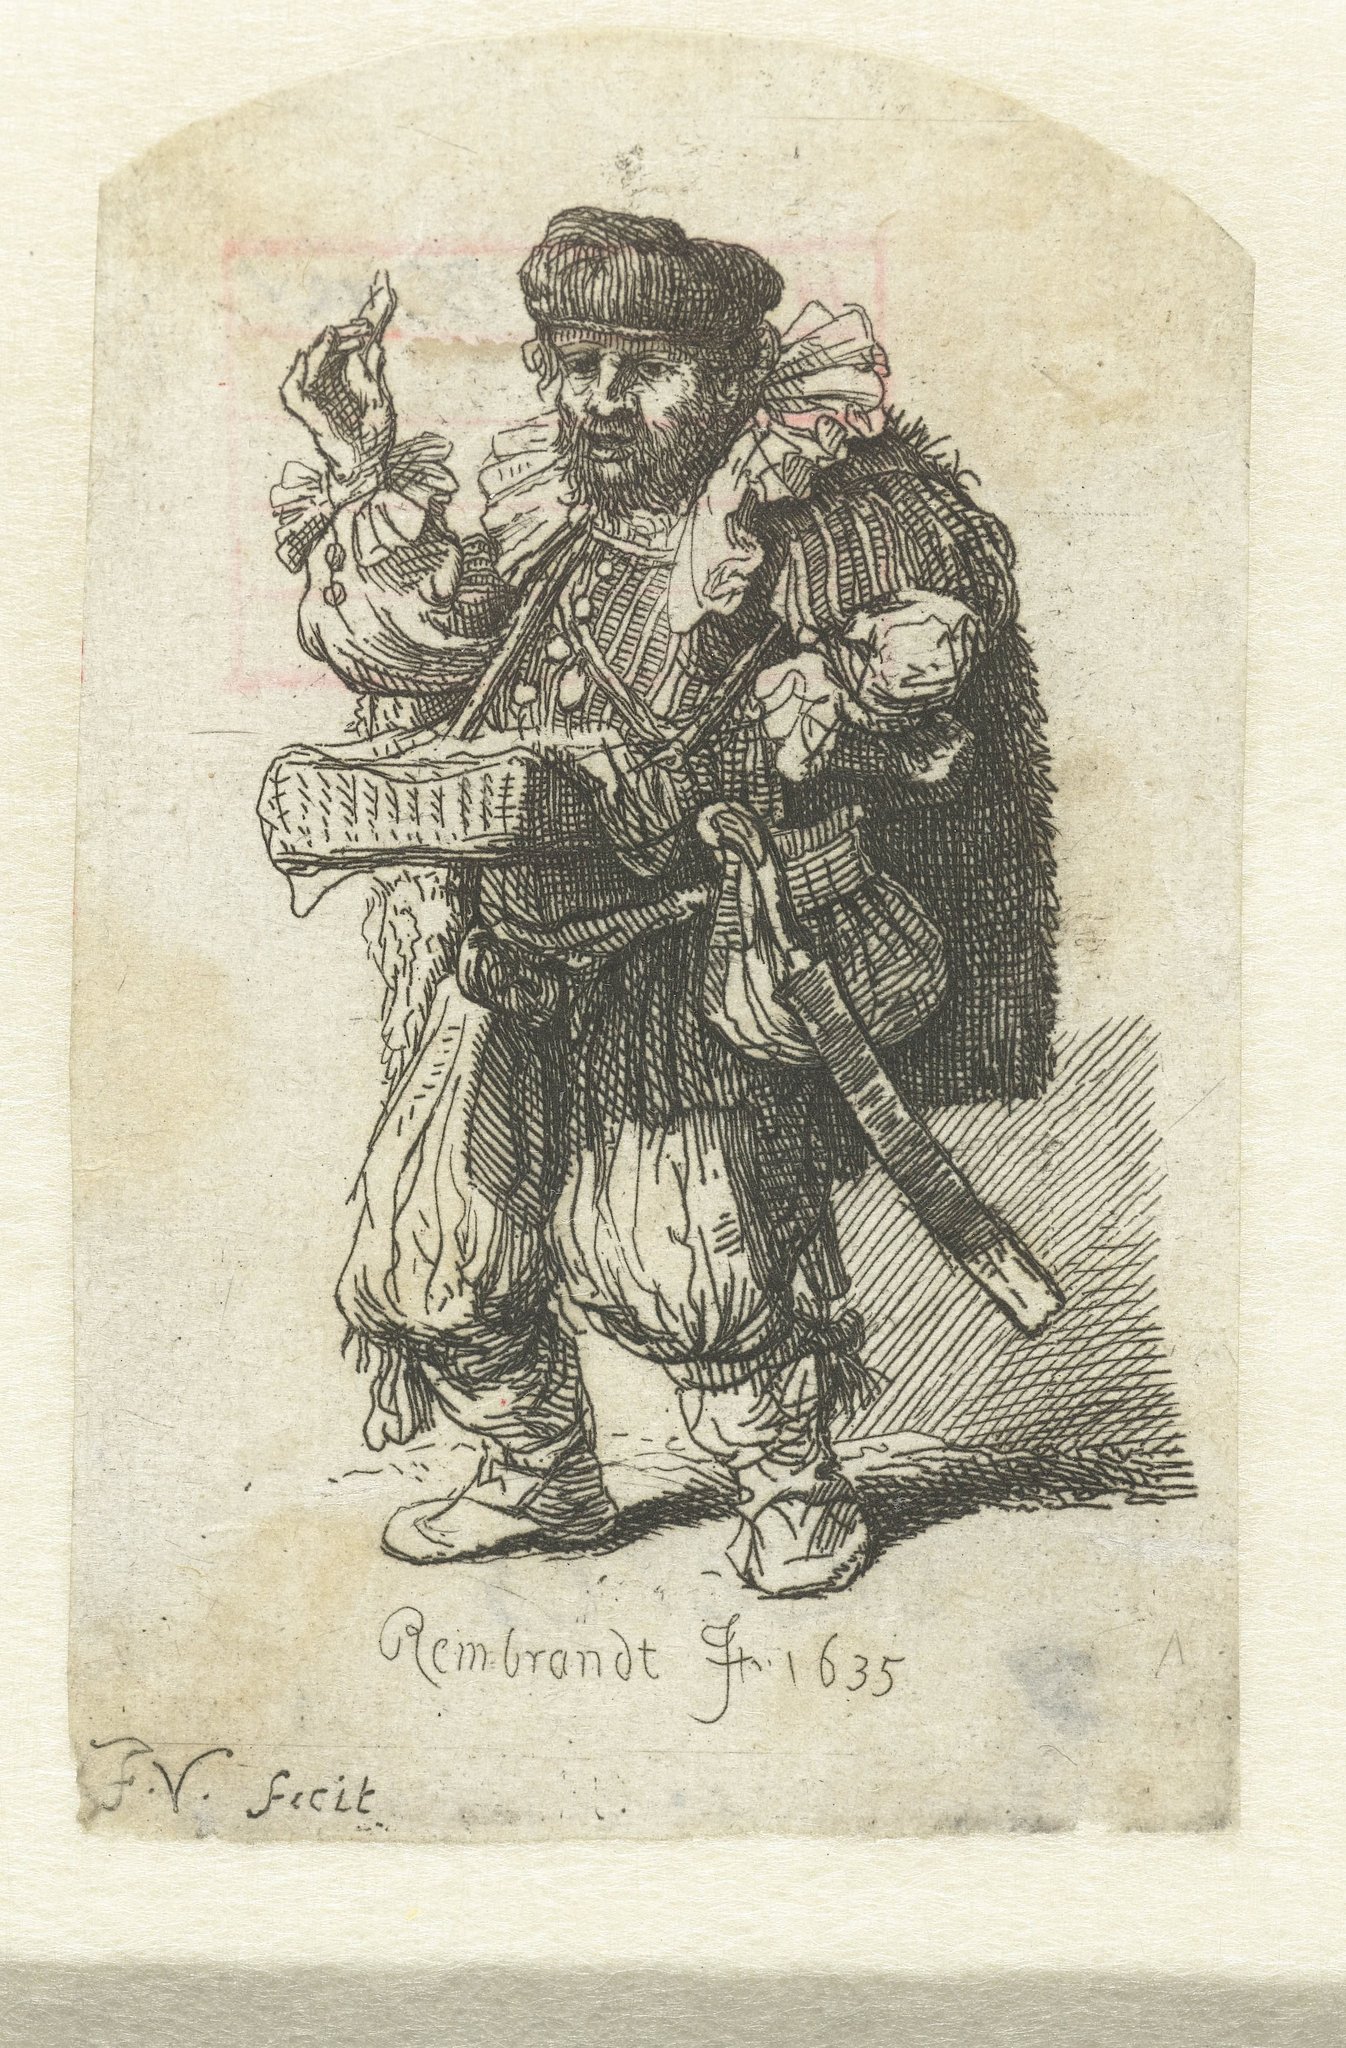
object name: print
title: The quacksalver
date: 1719-1780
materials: paper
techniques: etching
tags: quack, charlatan, mountebank, 'saltimbanco'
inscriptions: collector's mark: Lugt 2760, collector's mark: Lugt 2228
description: Spiegelbeeldige kopie naar de gelijknamige prent van Rembrandt.